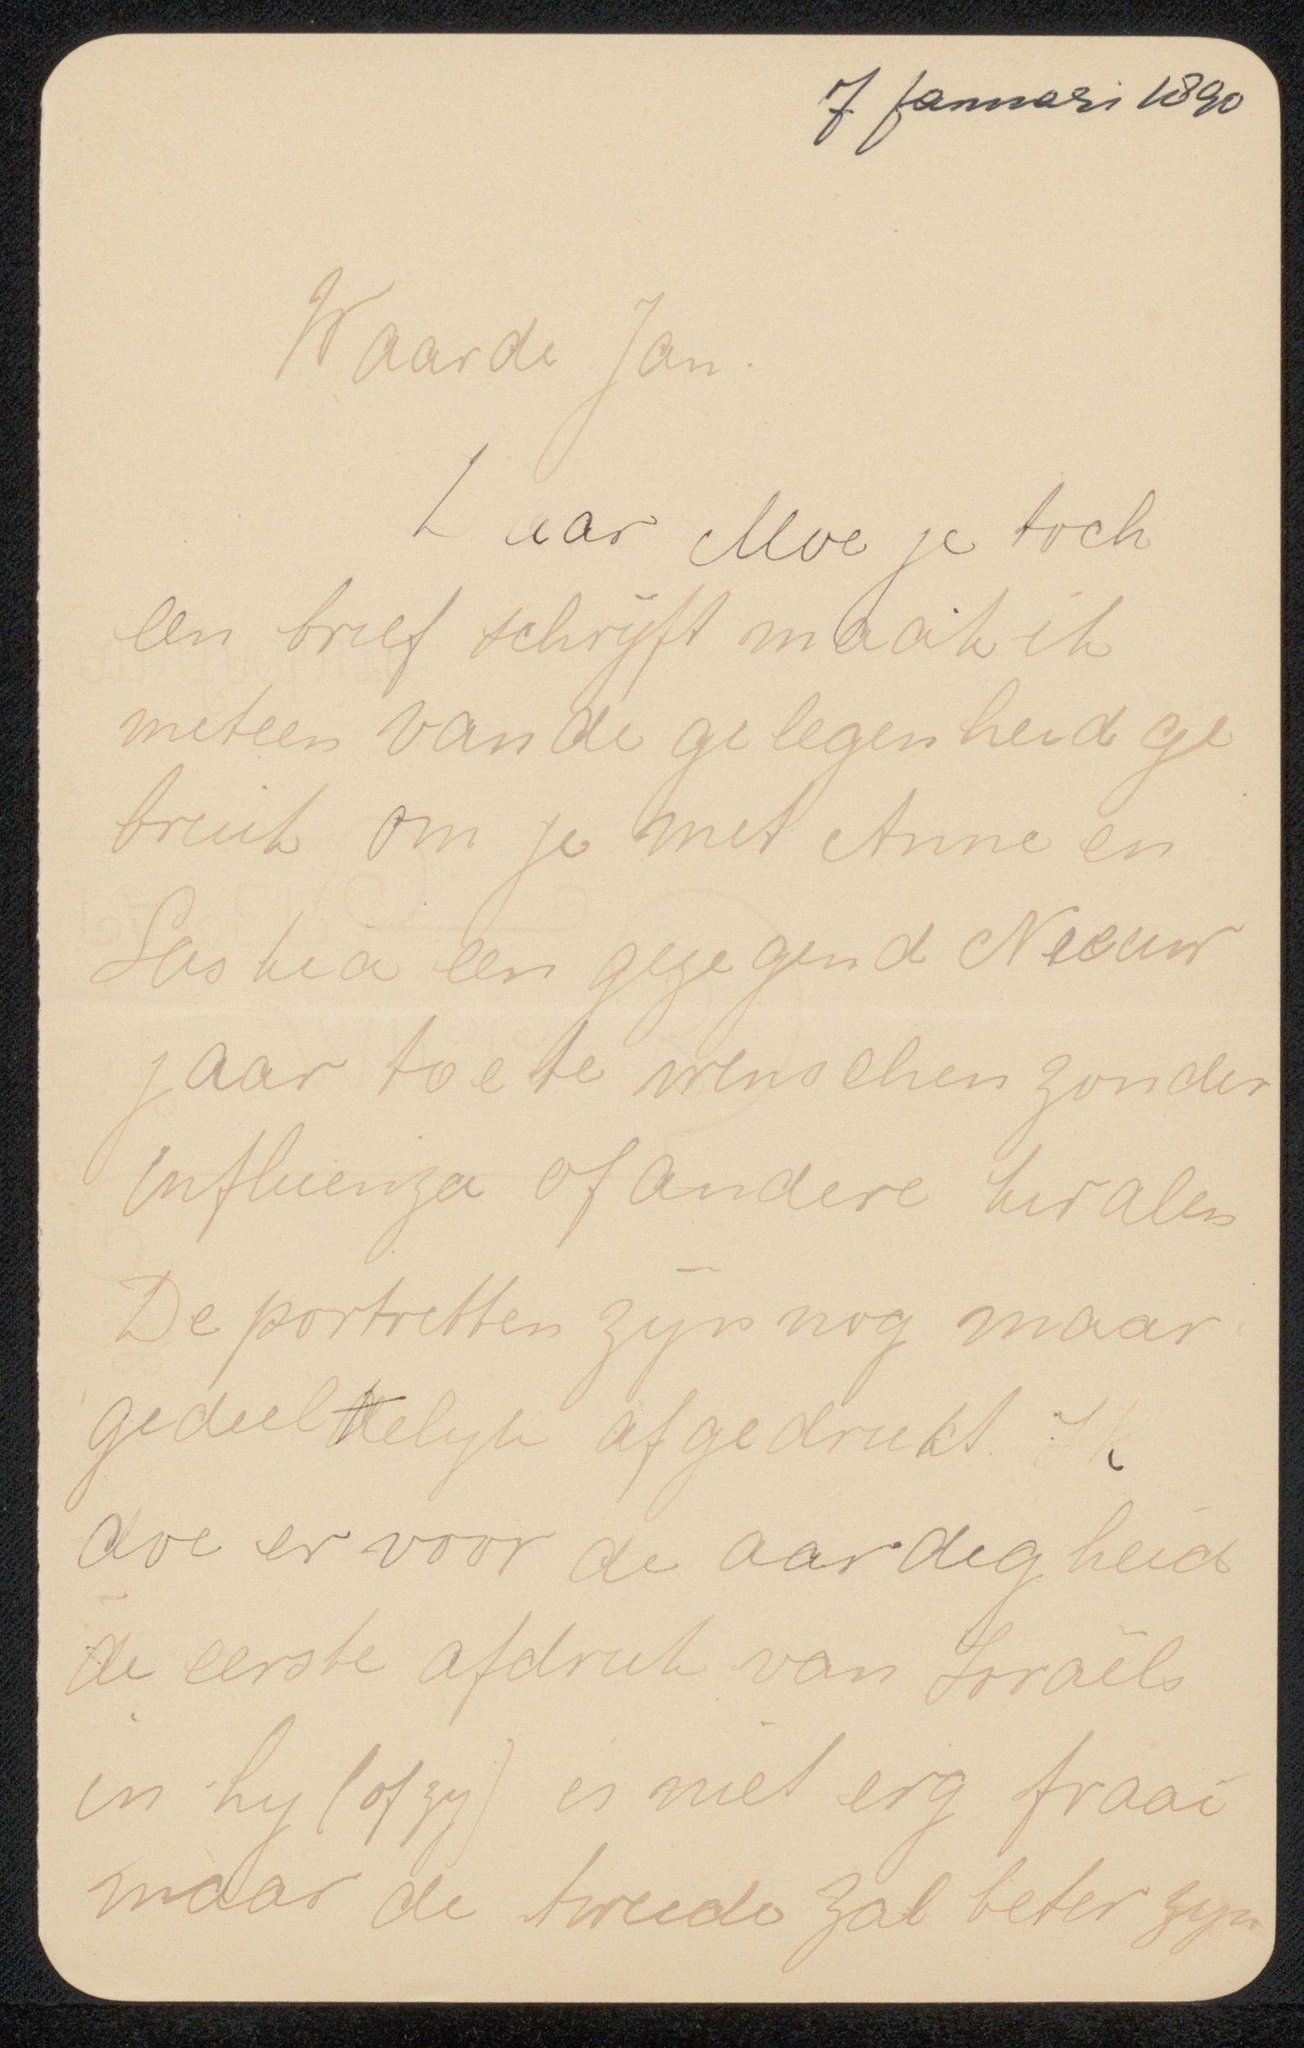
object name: letter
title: Brief aan Jan Veth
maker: andré jolles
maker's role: journalist, kunsthistoricus, letterkundige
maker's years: 1874-1946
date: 1890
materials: ink, paper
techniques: pen, writing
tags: dordrecht, amsterdam, painter, draughtsman, designer, jan veth, diseases, historical persons (portraits and scenes from the life)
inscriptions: watermark, collector's mark: ‘RPK’